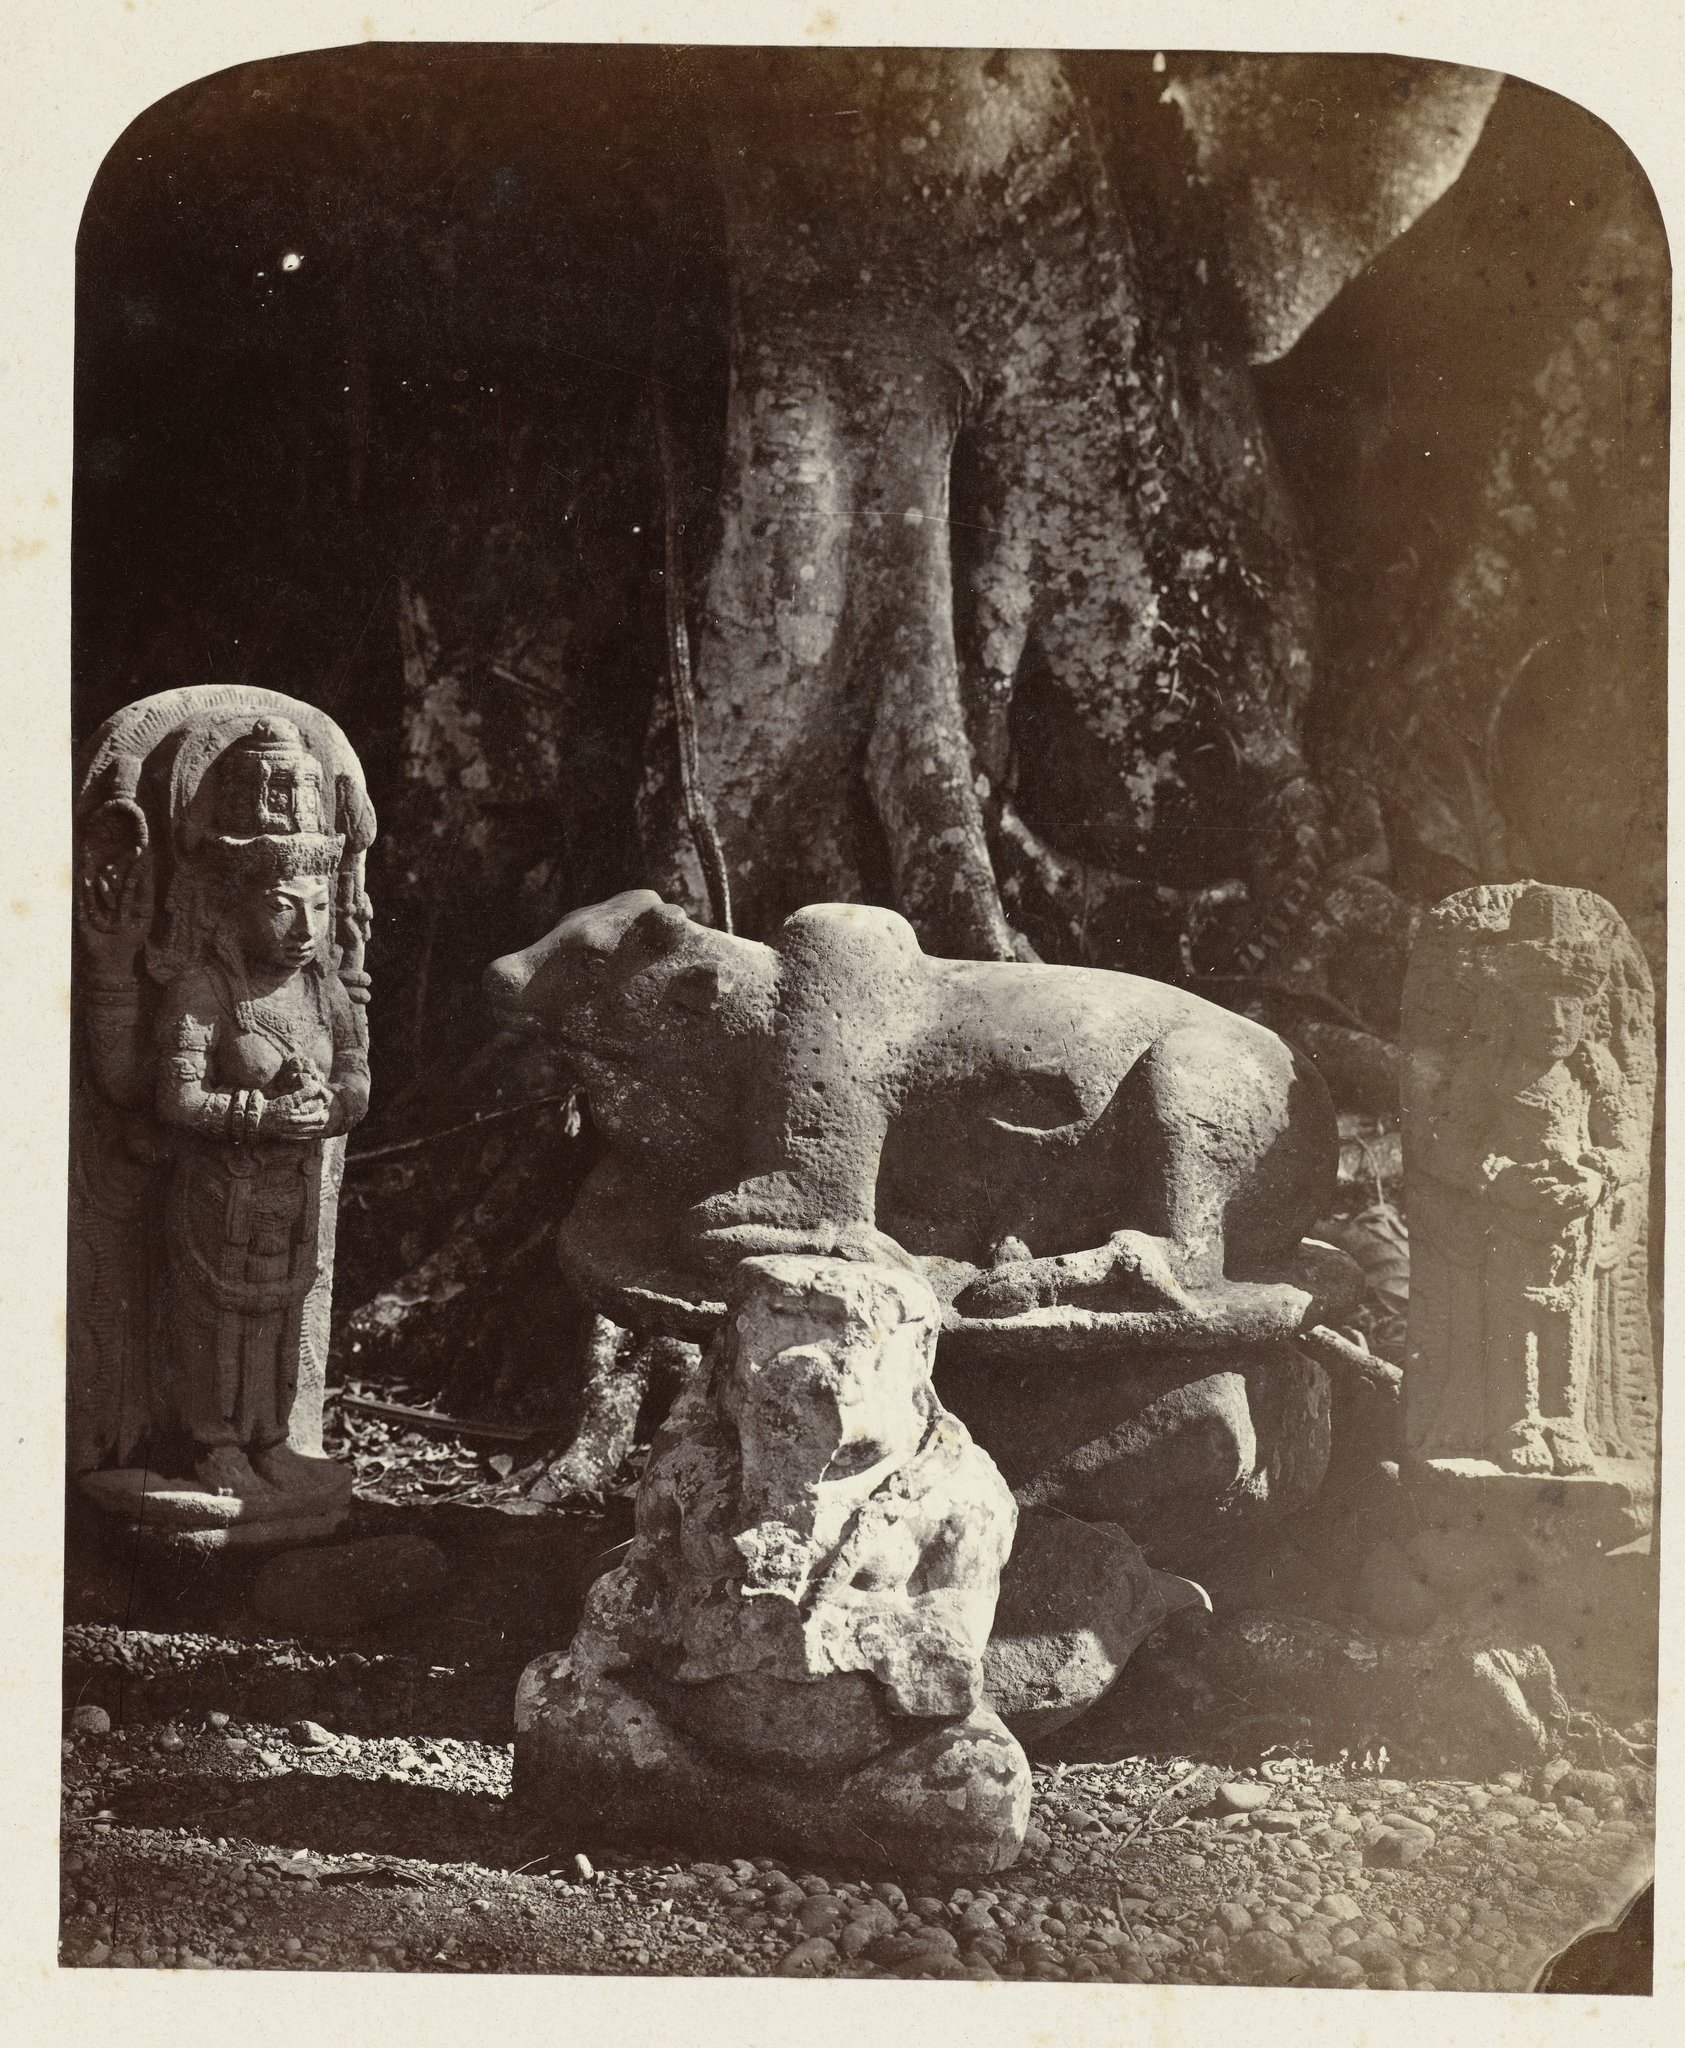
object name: photograph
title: Stone scultures from east Java exhibited at the Botanical Gardens in Bogor: deification statue in the form of the godess Parvati; Nandi, male deification statue and Ganesha. Bogor, Bogor district, West Java province 13th-14th century.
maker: isidore kinsbergen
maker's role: fotograaf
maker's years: 1821-1905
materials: cardboard, paper, photographic support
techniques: albumen print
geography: java